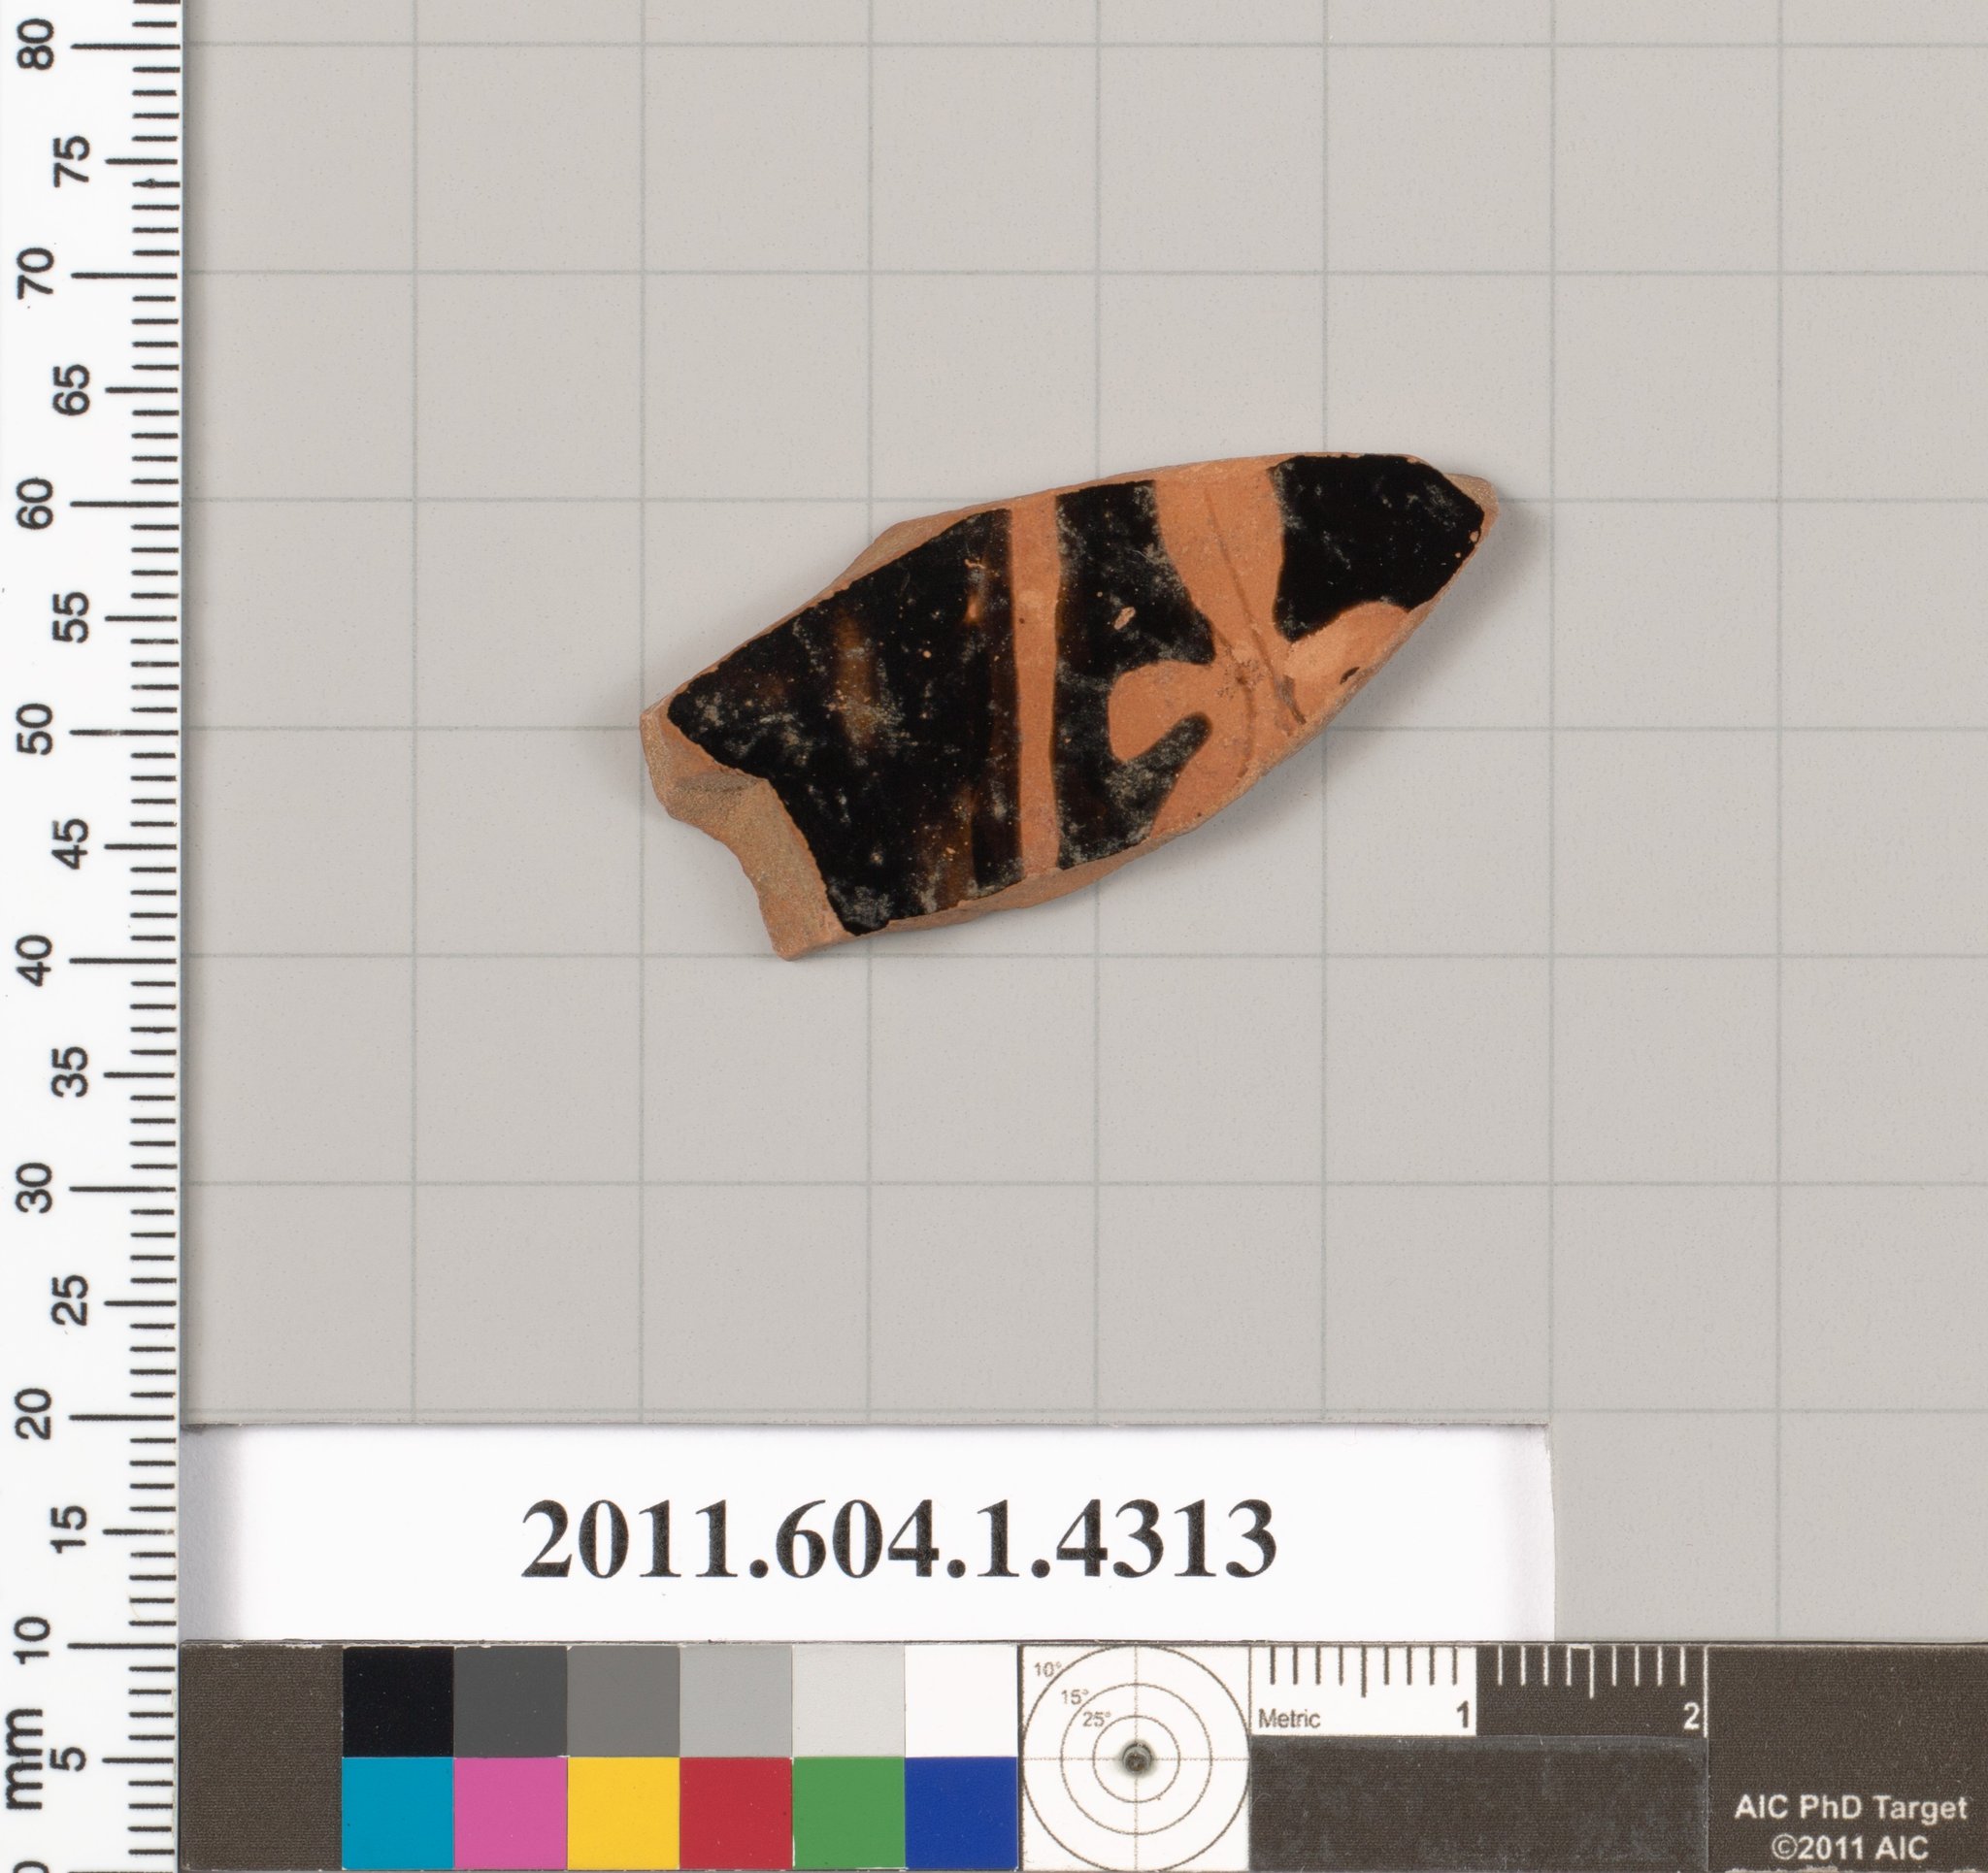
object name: kylix fragment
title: Terracotta fragment of a kylix (drinking cup)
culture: greek, attic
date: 500-451 BCE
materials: terracotta